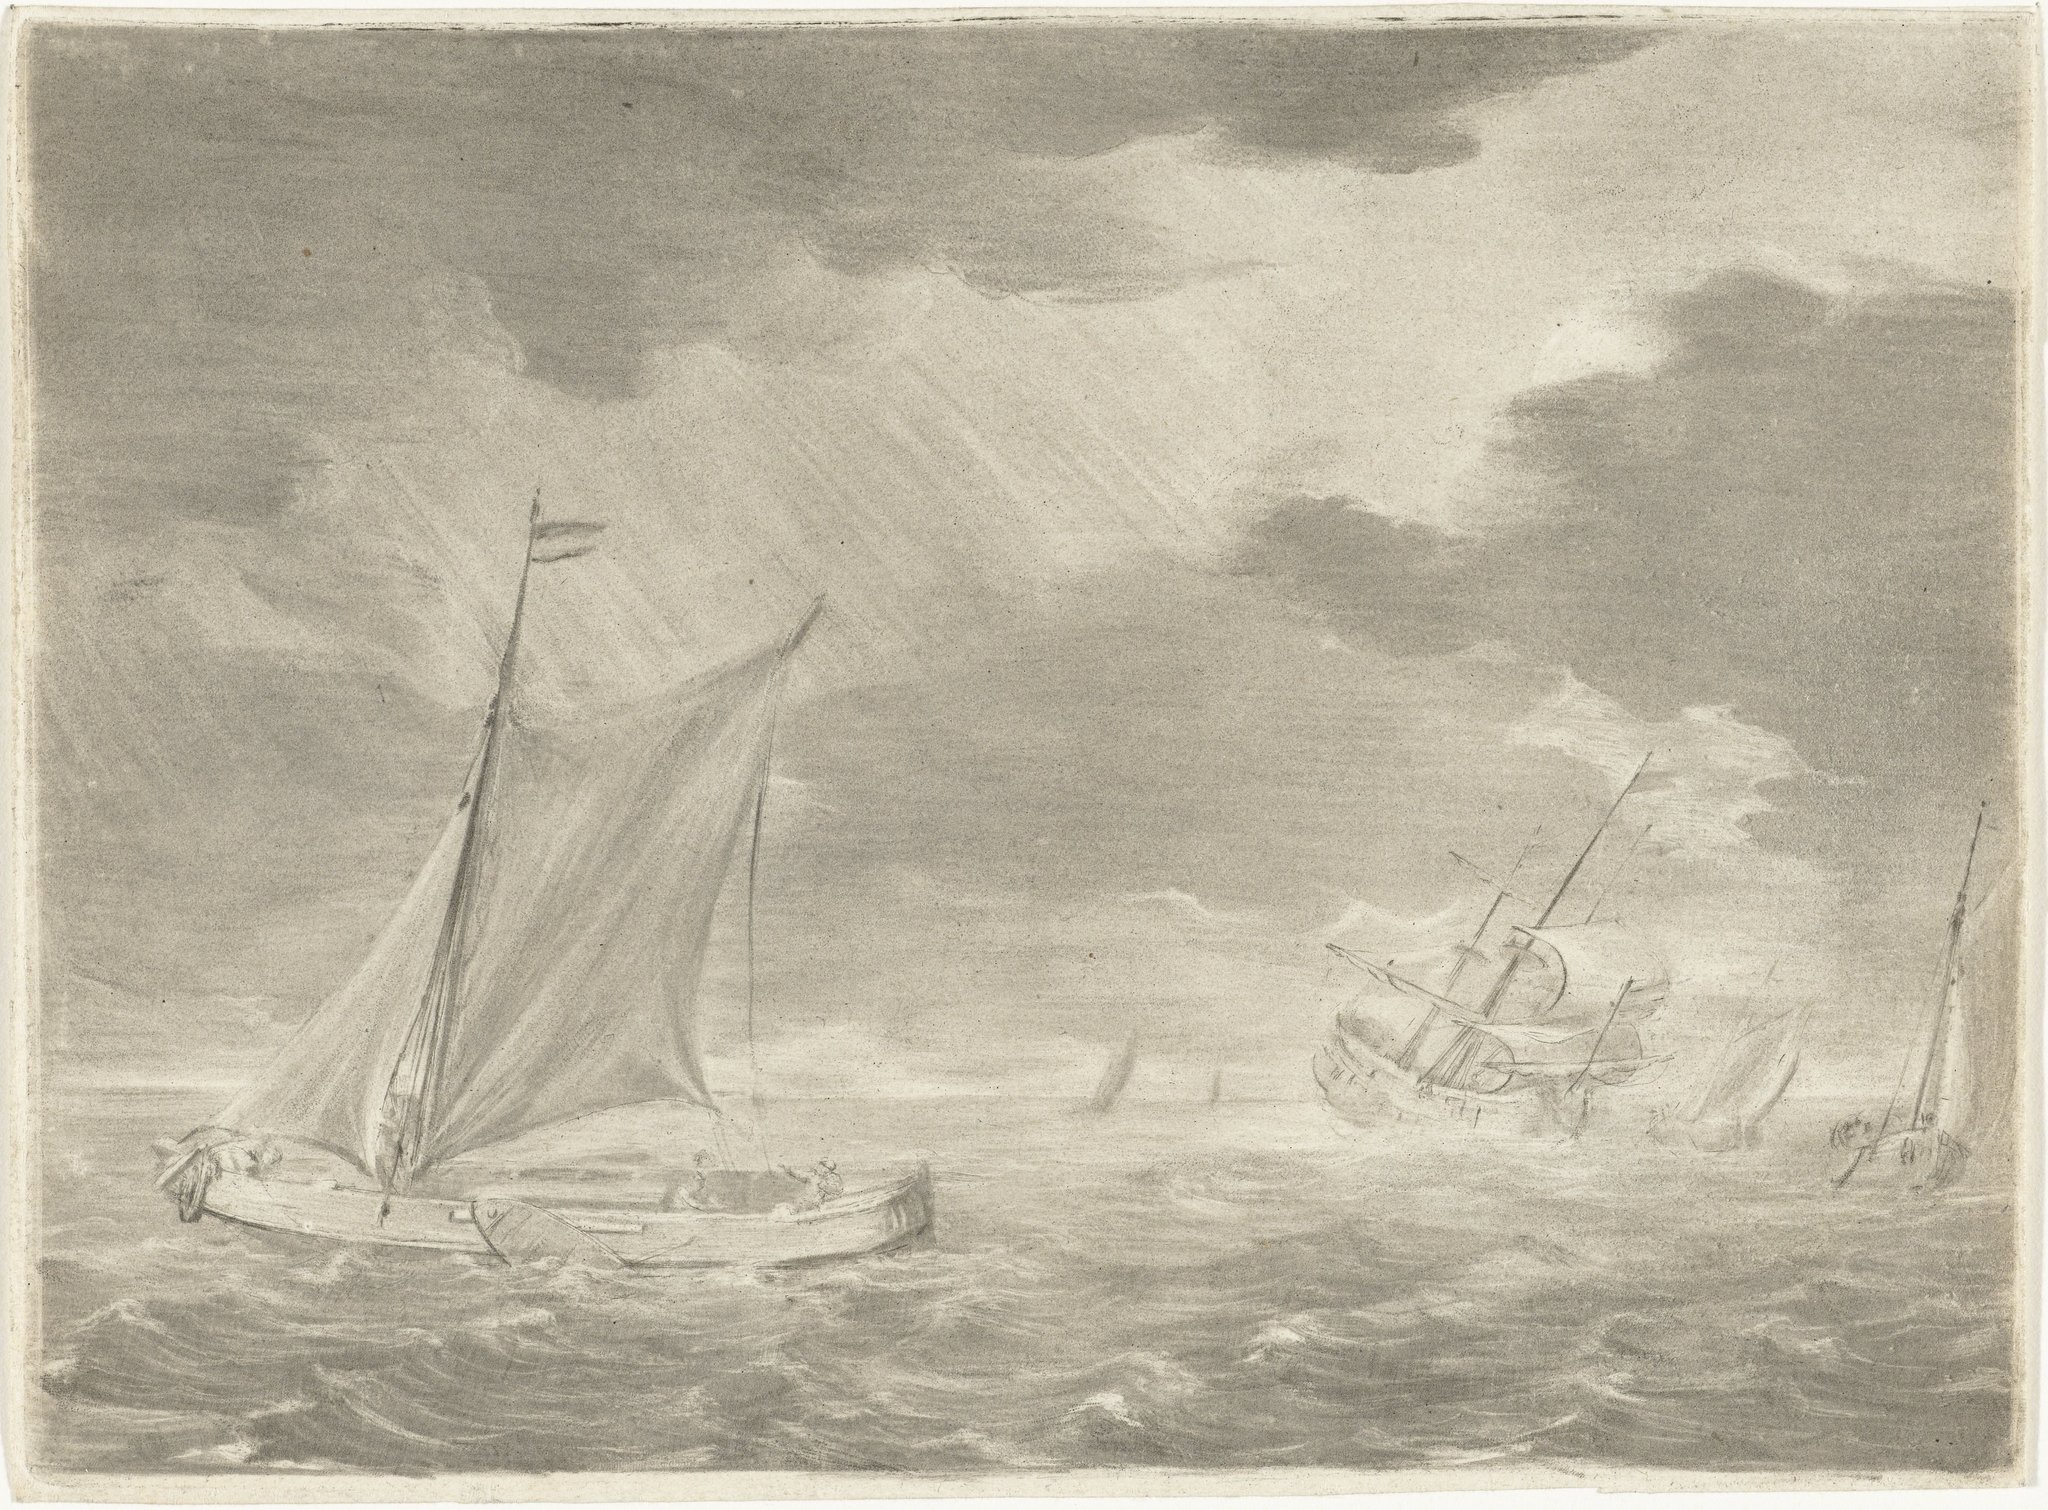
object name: print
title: Zeegezicht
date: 1761-1798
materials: paper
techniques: print drawing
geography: rotterdam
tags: sea (+ landscape with figures, staffage)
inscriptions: collector's mark: Lugt 2228